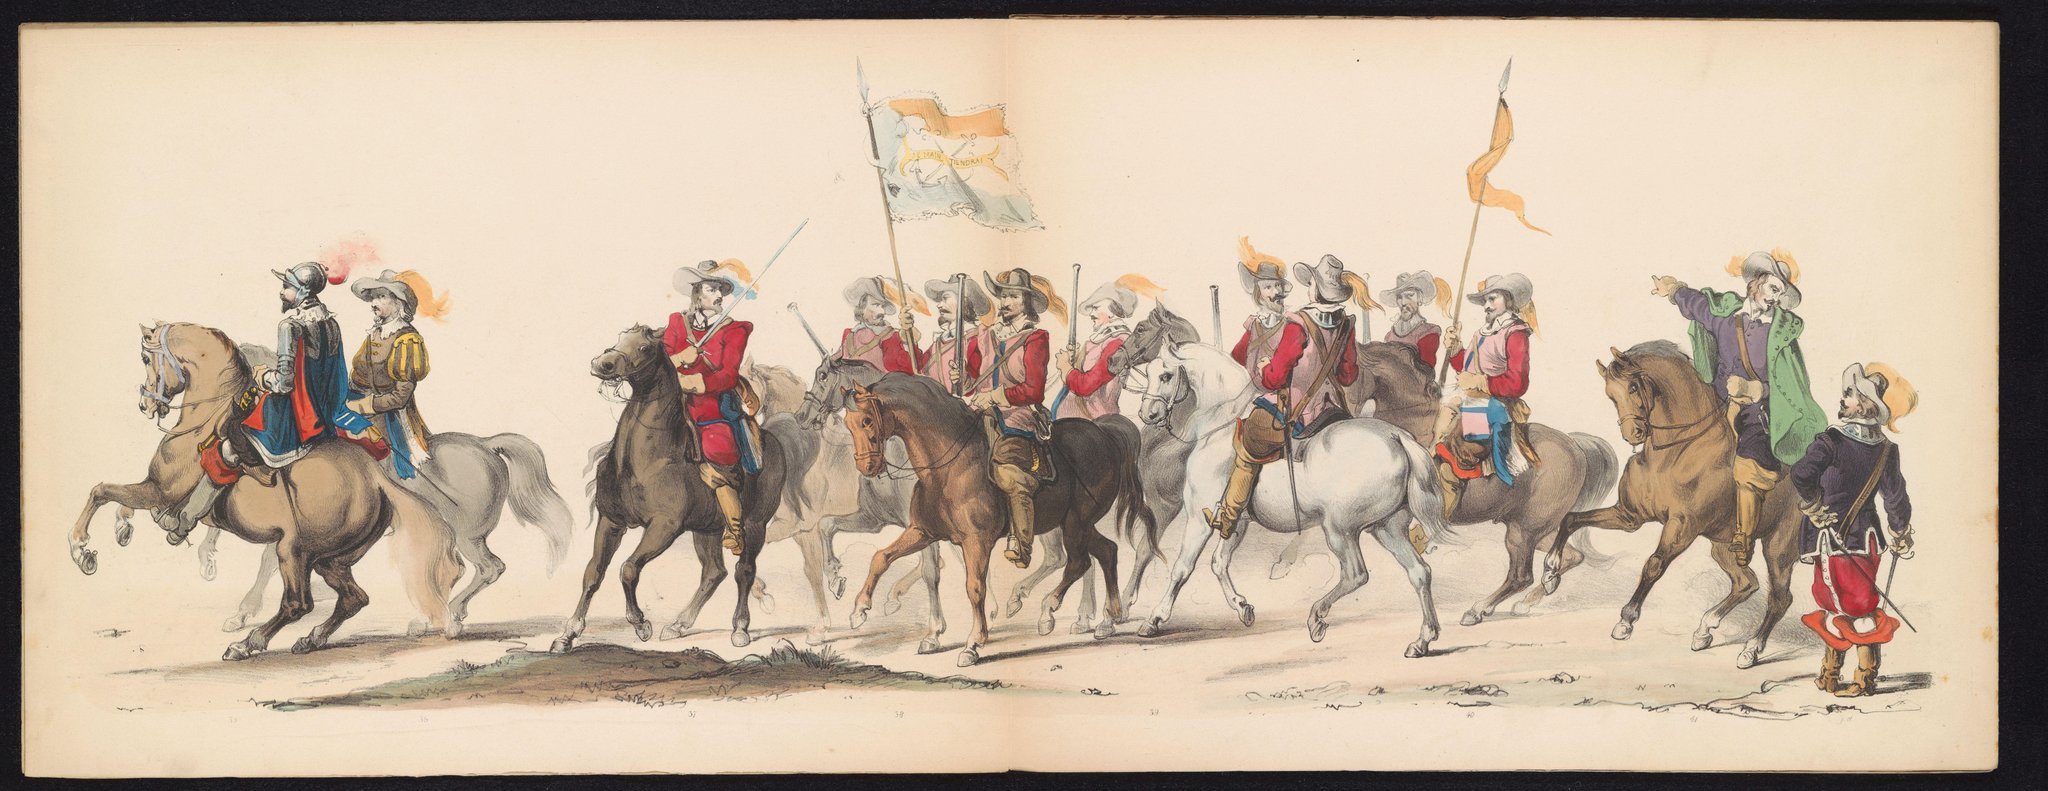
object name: print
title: Intogt van Frederik Hendrik in 's Hertogenbosch in 1629 : gecostumeerde voorstelling door de H.H. studenten der Leydsche Hoogeschool den XI Junij van het jaar 1850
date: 1850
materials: paper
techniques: lithograph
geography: leiden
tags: frederick henry (prince of orange), students' pageant, costumes used in pageants, leiden, den bosch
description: Historische gekostumeerde optocht van de studenten van de Leidse Hogeschool op 11 juni 1850. De optocht verbeeldt de intocht van Frederik Hendrik te Den Bosch in 1629. Vierde plaat met de groepen genummerd 35-41. Onderdeel van de serie van dertien aanelkaar geplakte bladen.